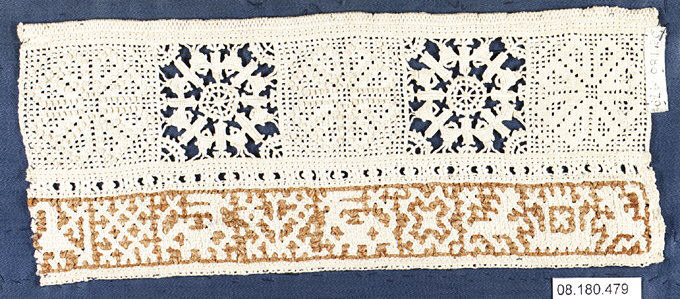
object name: border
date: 1501-1600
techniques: embroidery, lace